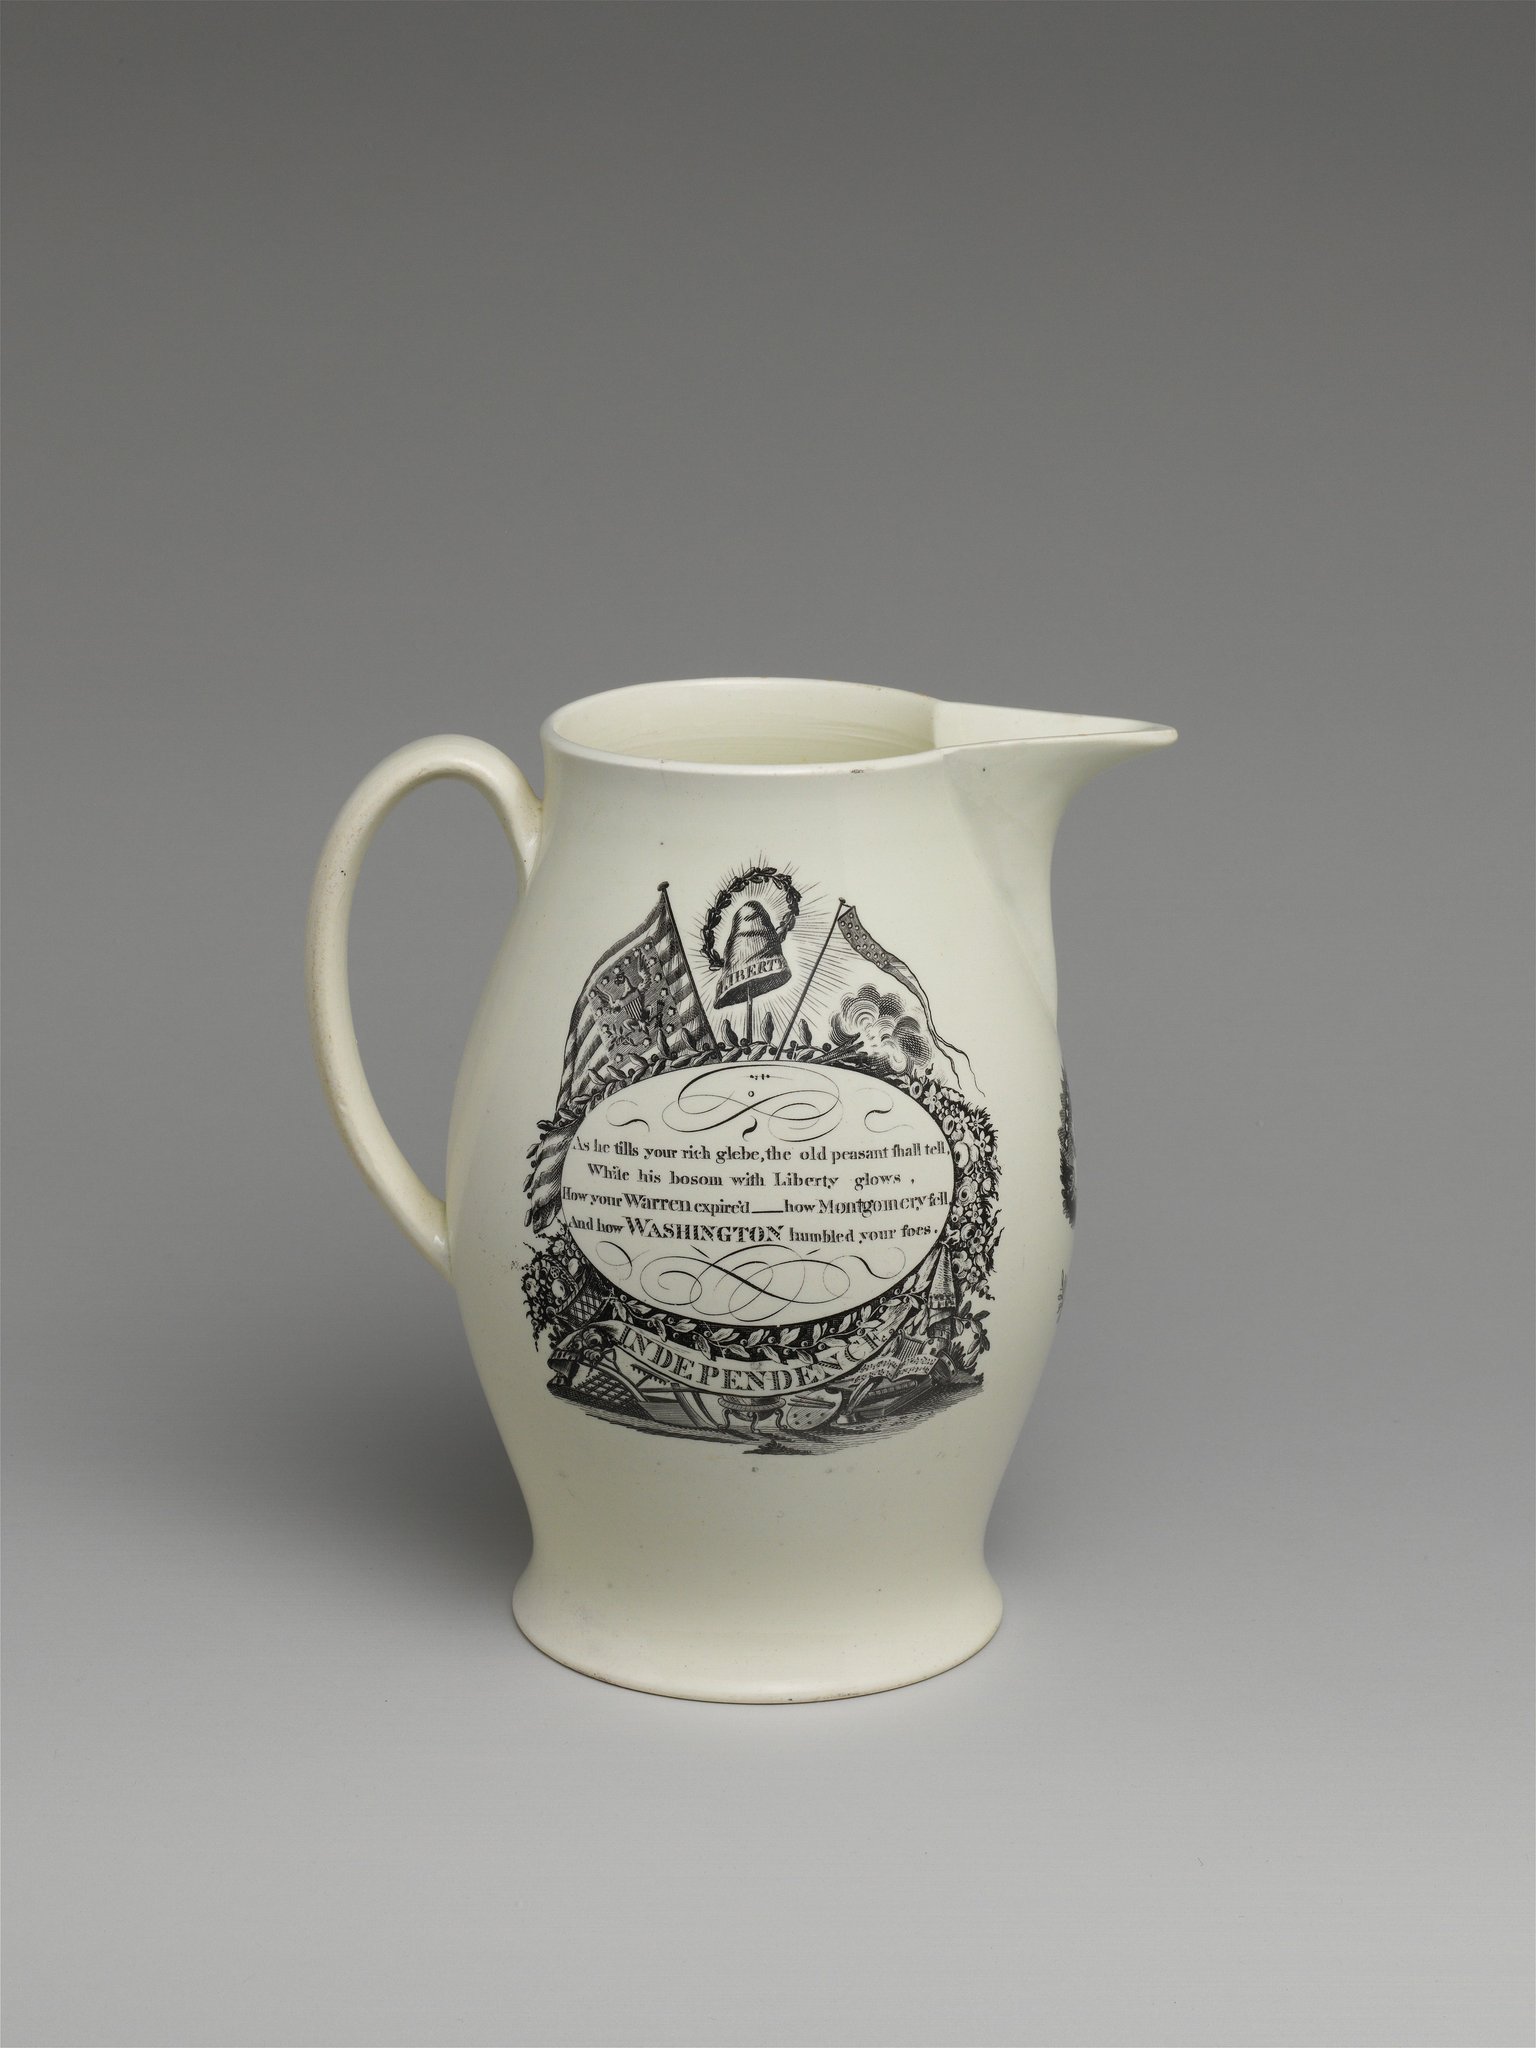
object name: pitcher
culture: british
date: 1800-1810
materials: earthenware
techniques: transfer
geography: england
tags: george washington,maps